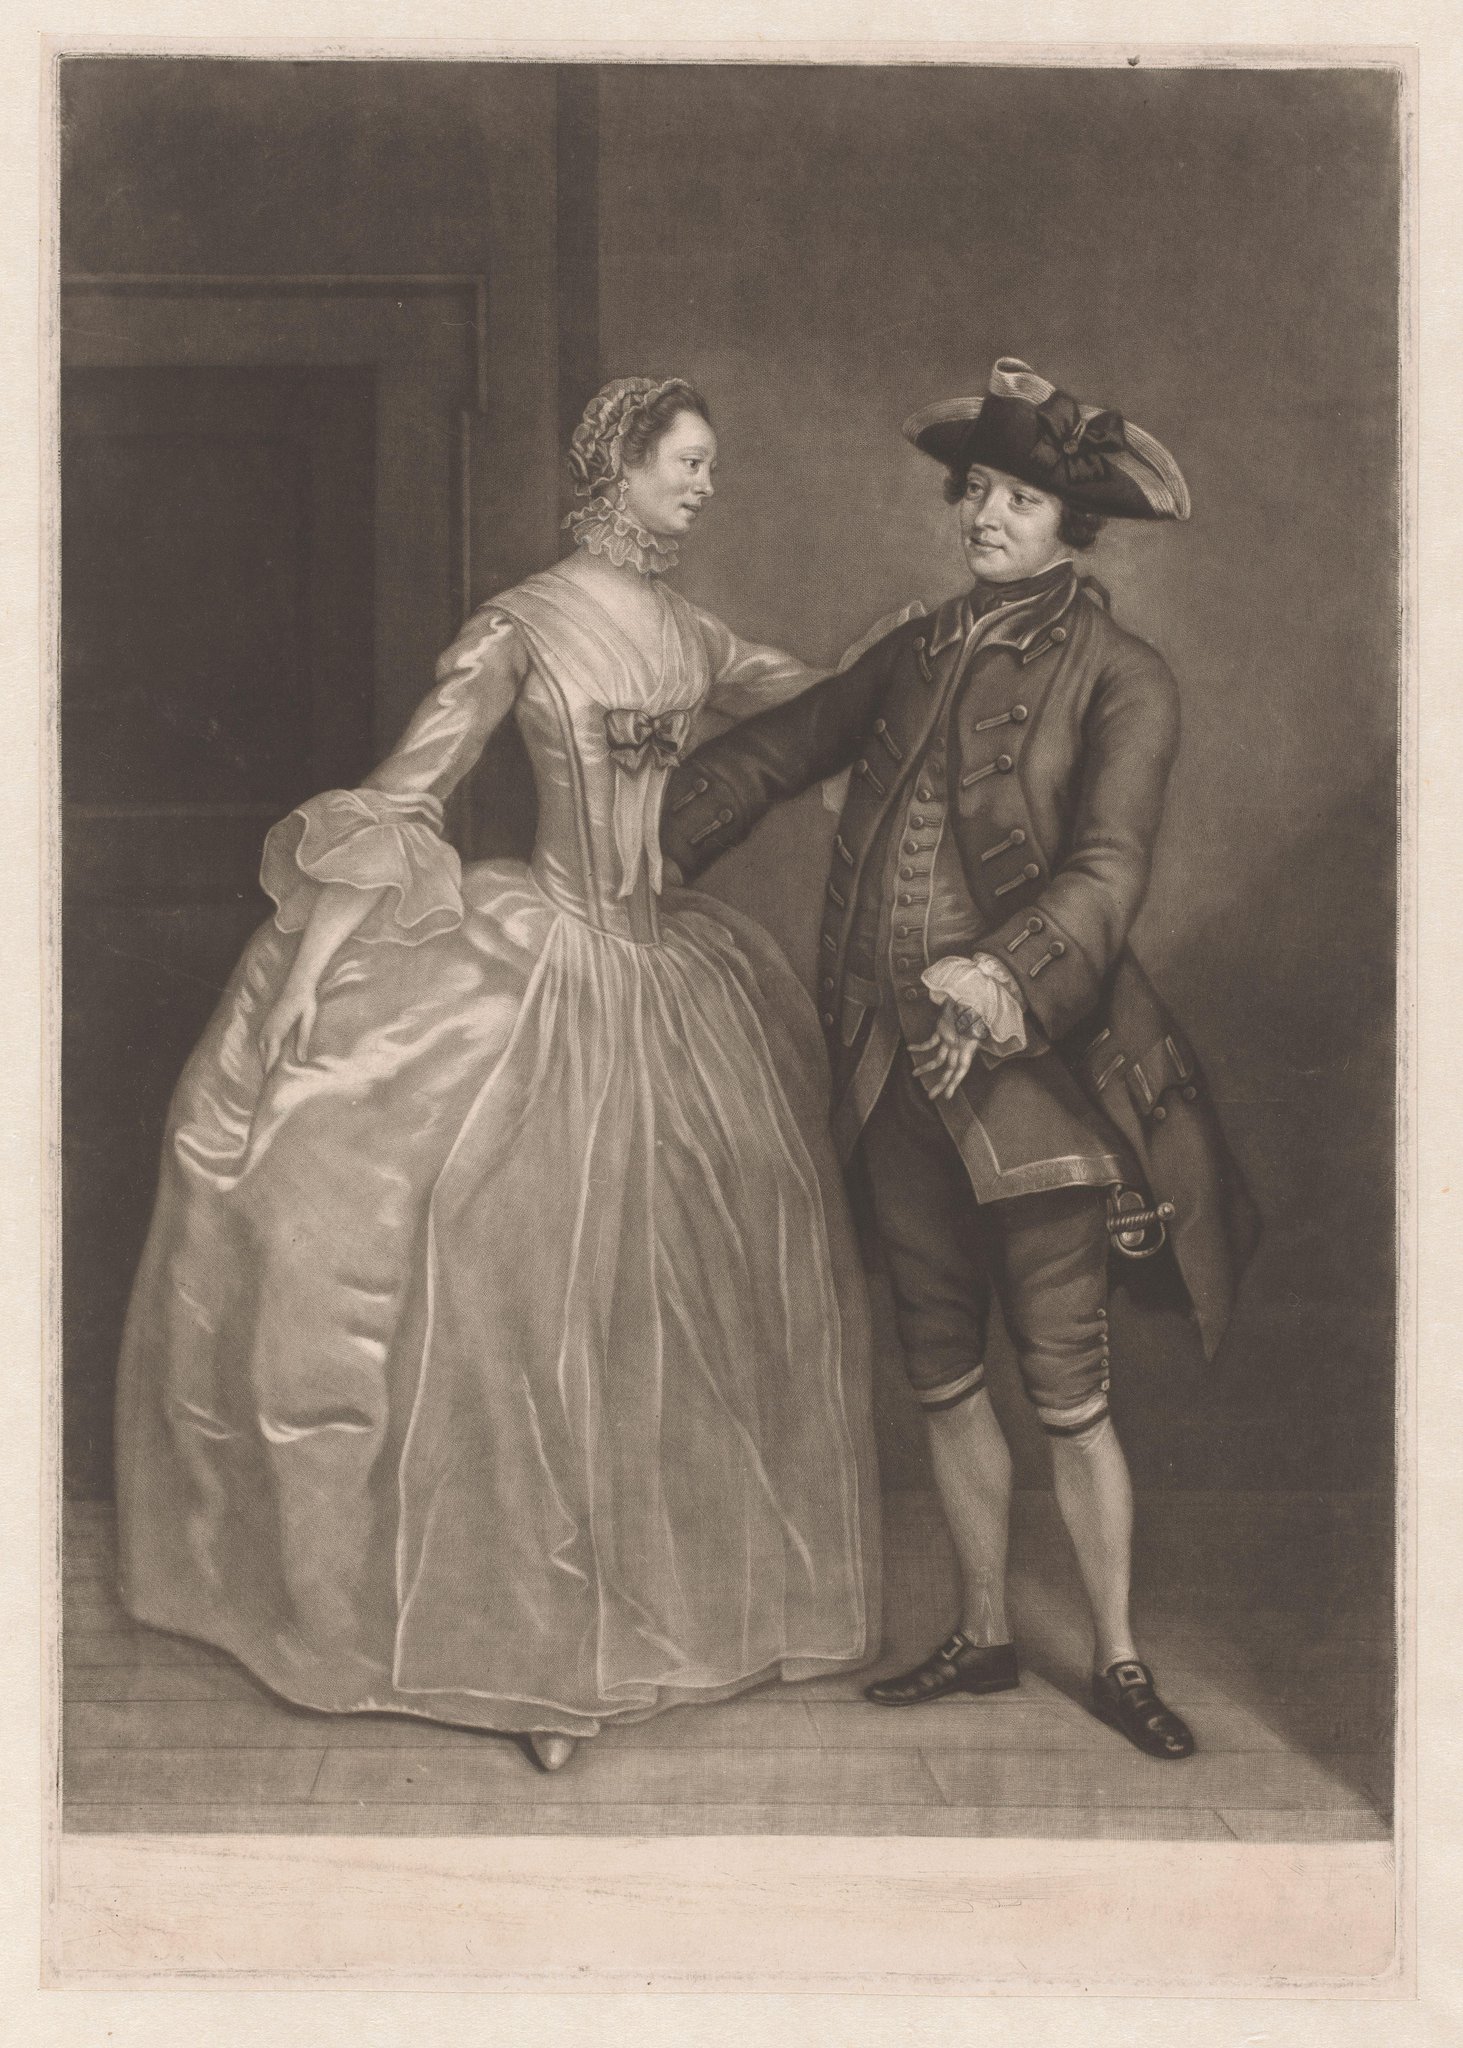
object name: print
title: Portret van Thomas Lowe en mevrouw Chambers als kapitein Macheath en Polly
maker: james mcardell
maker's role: print maker, publisher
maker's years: 1728-1765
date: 1752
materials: paper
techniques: mezzotint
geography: london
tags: historical person in a double portrait, portrait of actor, actress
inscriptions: collector's mark: Lugt 240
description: Lowe en Chambers als karakters uit John Gays 'De opera van de bedelaar'.